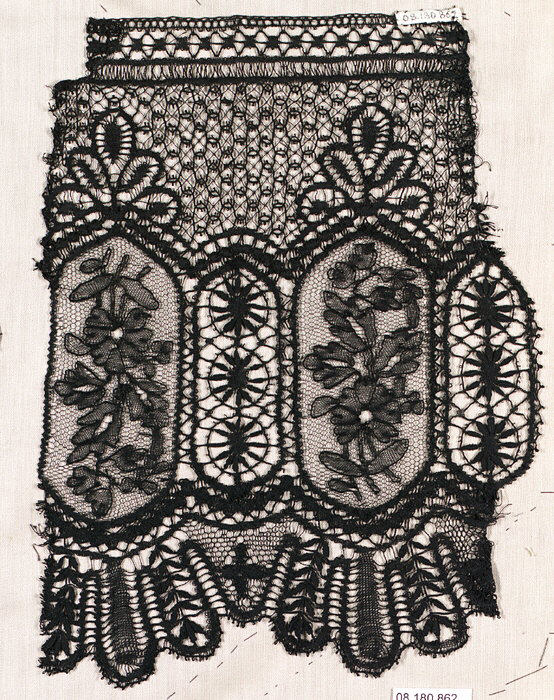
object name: fragment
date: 1801-1900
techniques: lace